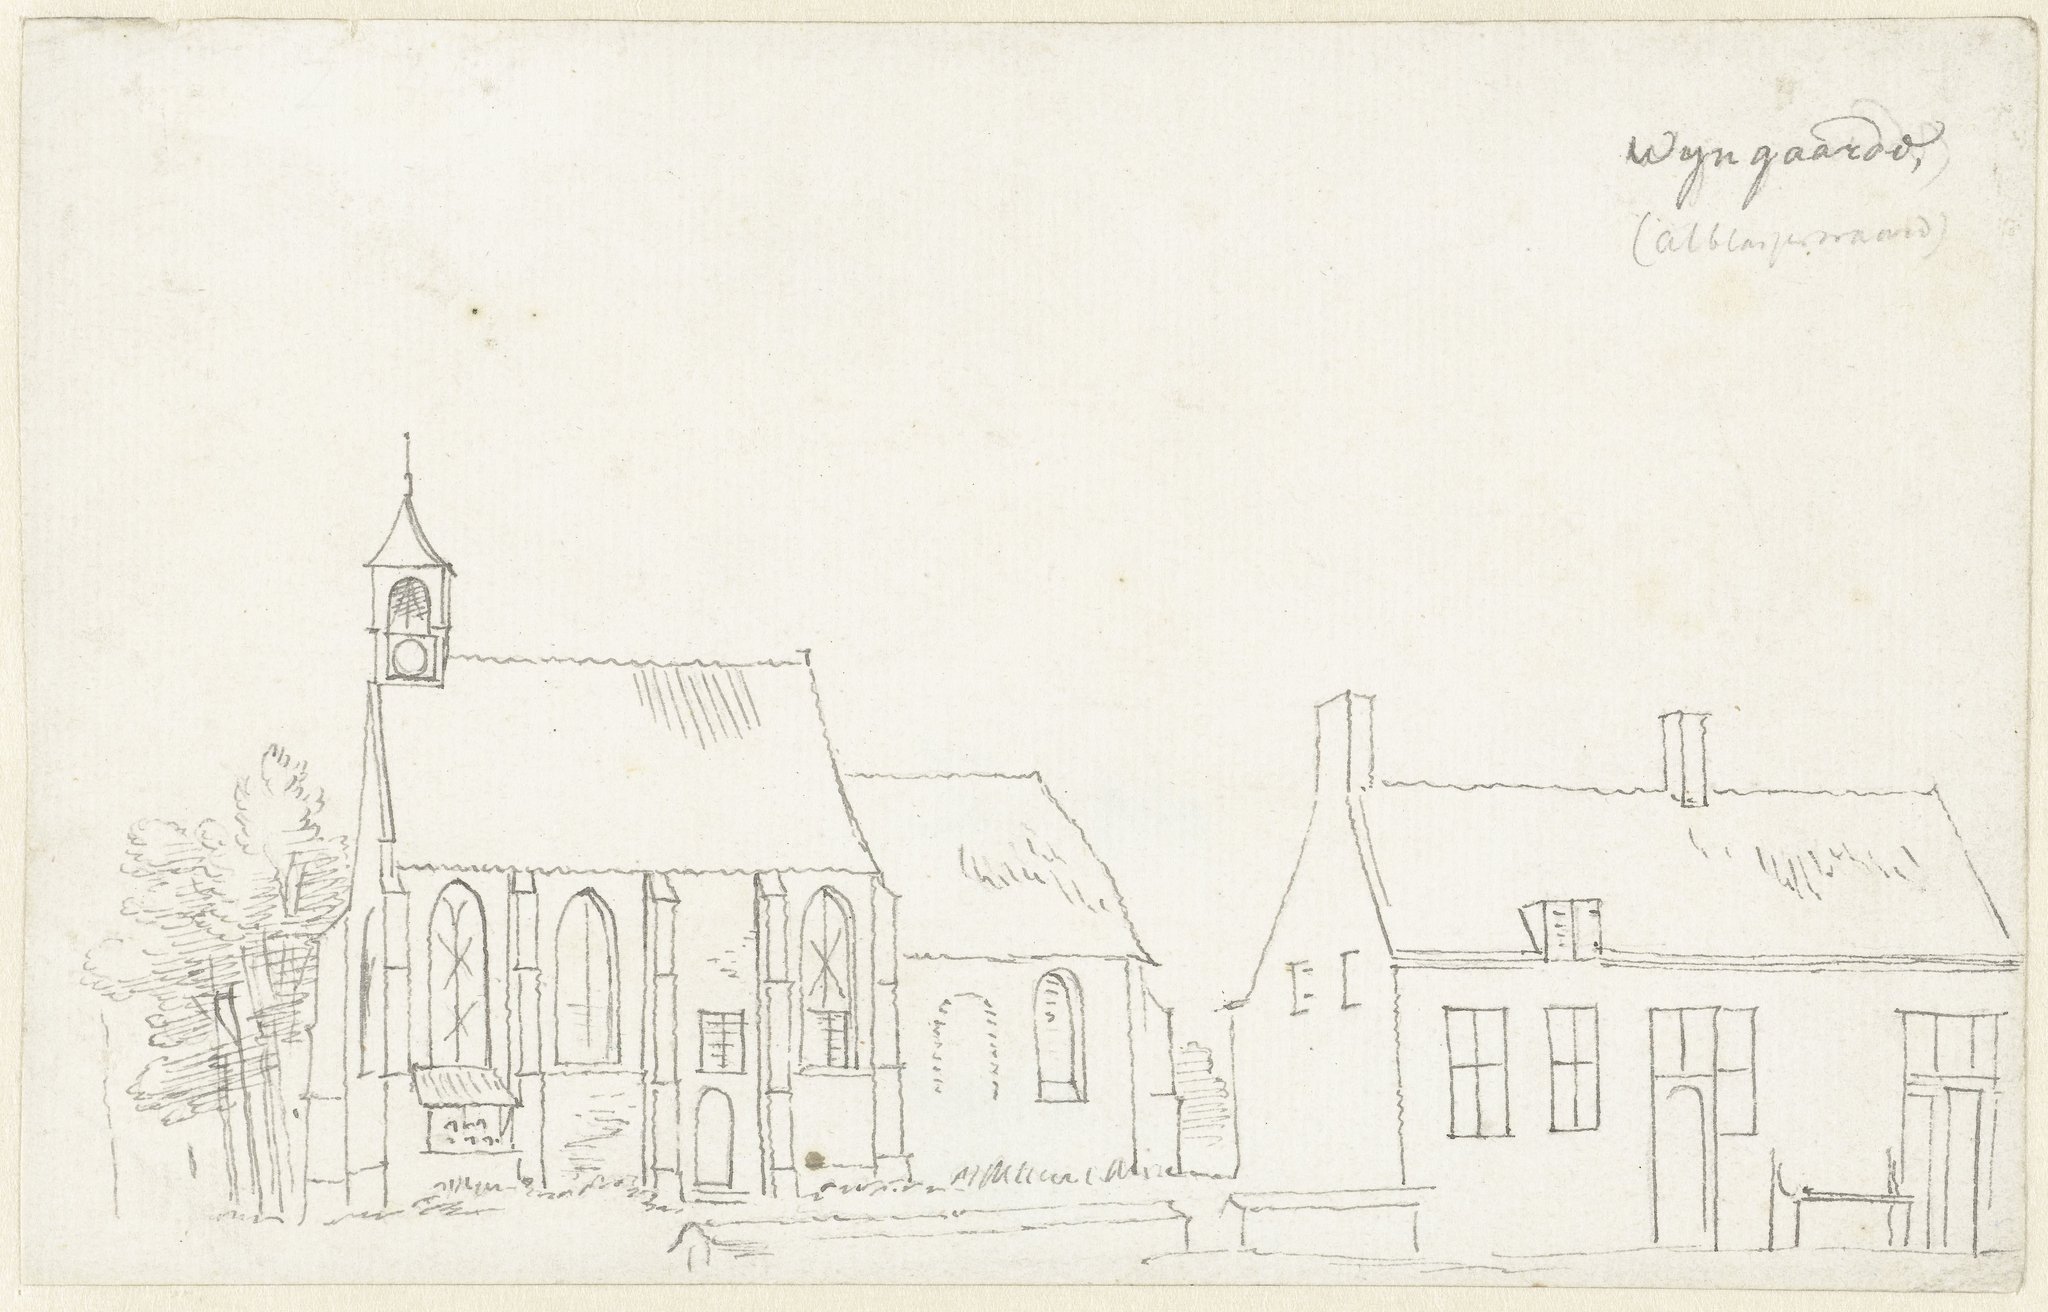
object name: drawing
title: Kerk in het dorp Wijngaarden, Alblasserwaard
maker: cornelis pronk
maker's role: draughtsman, painter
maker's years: 1691-1759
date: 1701-1759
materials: ink, paper, pencil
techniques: pen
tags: church (exterior), founding a village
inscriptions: inscription: ‘Wyngaarde, / (alblasserwaard)’